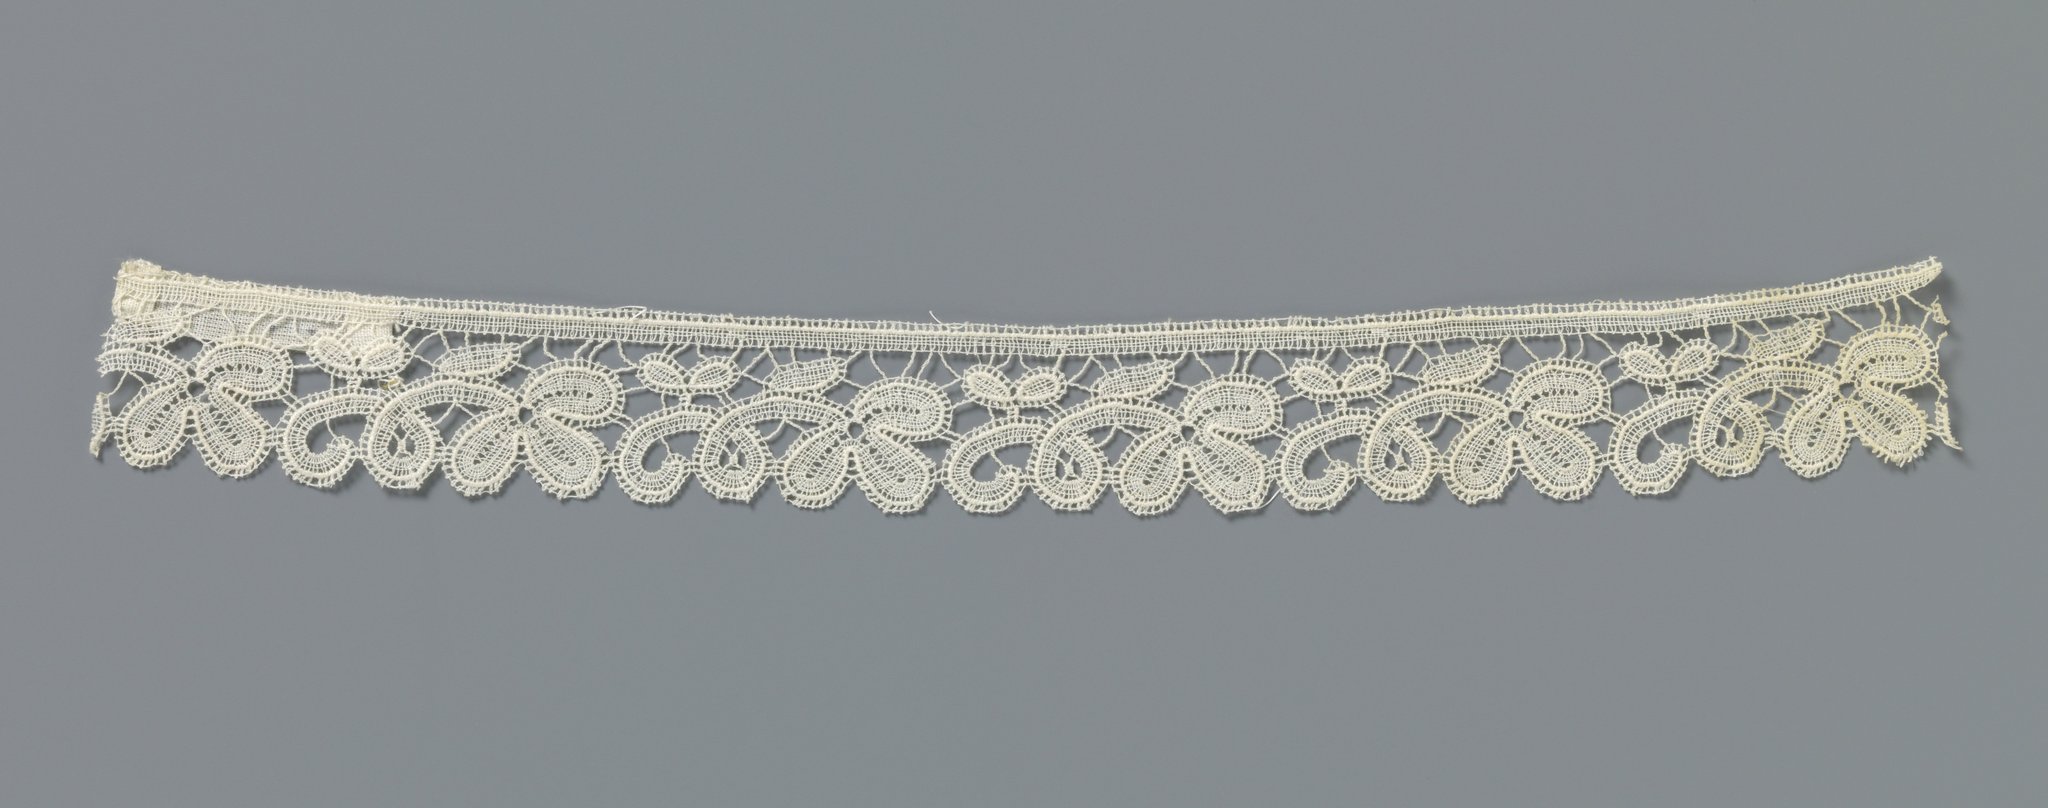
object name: strip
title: Strook machinale kant met drieblad aan een twee maal omkrullende steel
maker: Anonymous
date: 1875-1899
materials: cotton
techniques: lace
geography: europe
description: Strook naturelkleurige machinale kant: machinale Brusselse duchesse. Het zich herhalende patroon bestaat uit een drieblad met een twee maal omkrullende steel die langs de onderzijde van de strook ligt. De motieven zijn gemaakt in linnenslag met opengewerkte randjes en contourdraden. De opeenvolgende bladeren met stelen zijn met elkaar verbonden door een machinale vlechtengrond. In de eerste lus die de omkrullende steel maakt is een blokje gemaakt, waarmee een gekloste vormslag gesuggereerd wordt. De bovenzijde van de strook is recht afgewerkt. De schulpenrand langs de onderzijde komt voort uit het patroon met het drieblad.